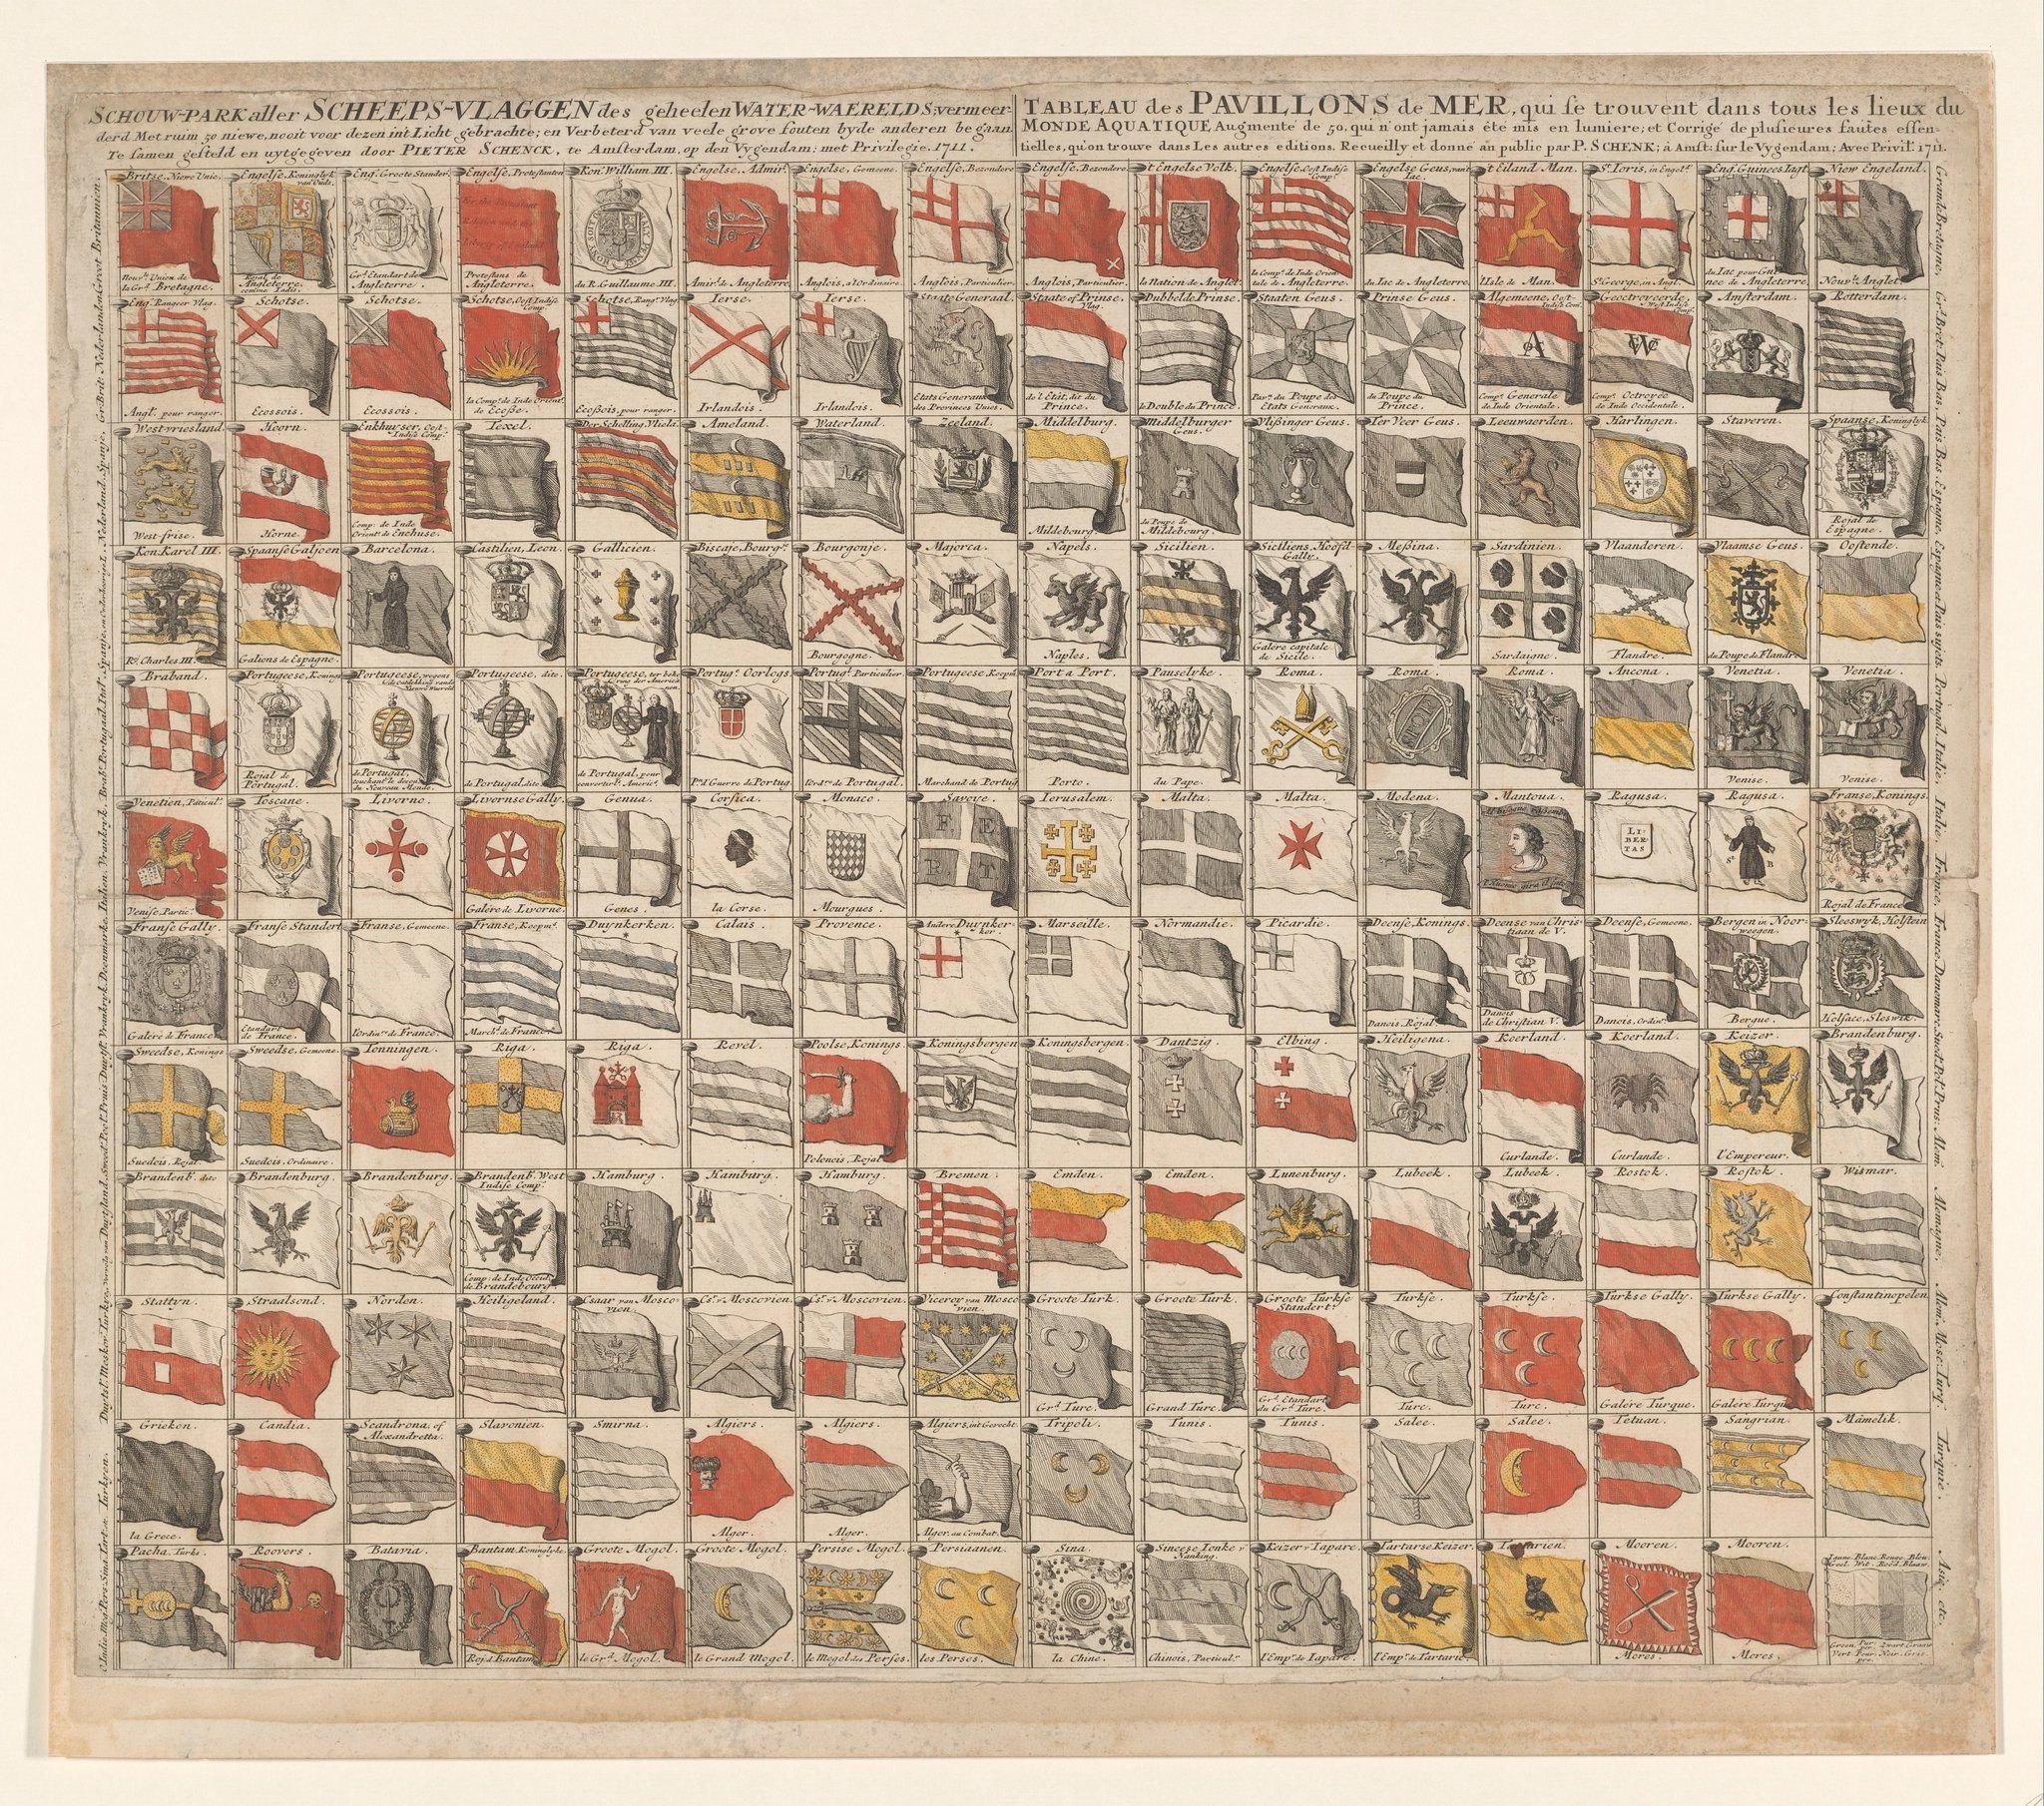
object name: print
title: Schouw-park aller Scheeps-vlaggen des geheelen Water-Waerelds; vermeerderd Met ruim 50 nieuwe, nooit voor dezen in 't Licht gebrachte (...)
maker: pieter schenk (i)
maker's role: print maker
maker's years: 1660-1711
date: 1711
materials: paper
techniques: etching, hand coloring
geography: amsterdam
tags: (military) flags and standards (+ naval force), flag, colours (as symbol of the state, etc.)